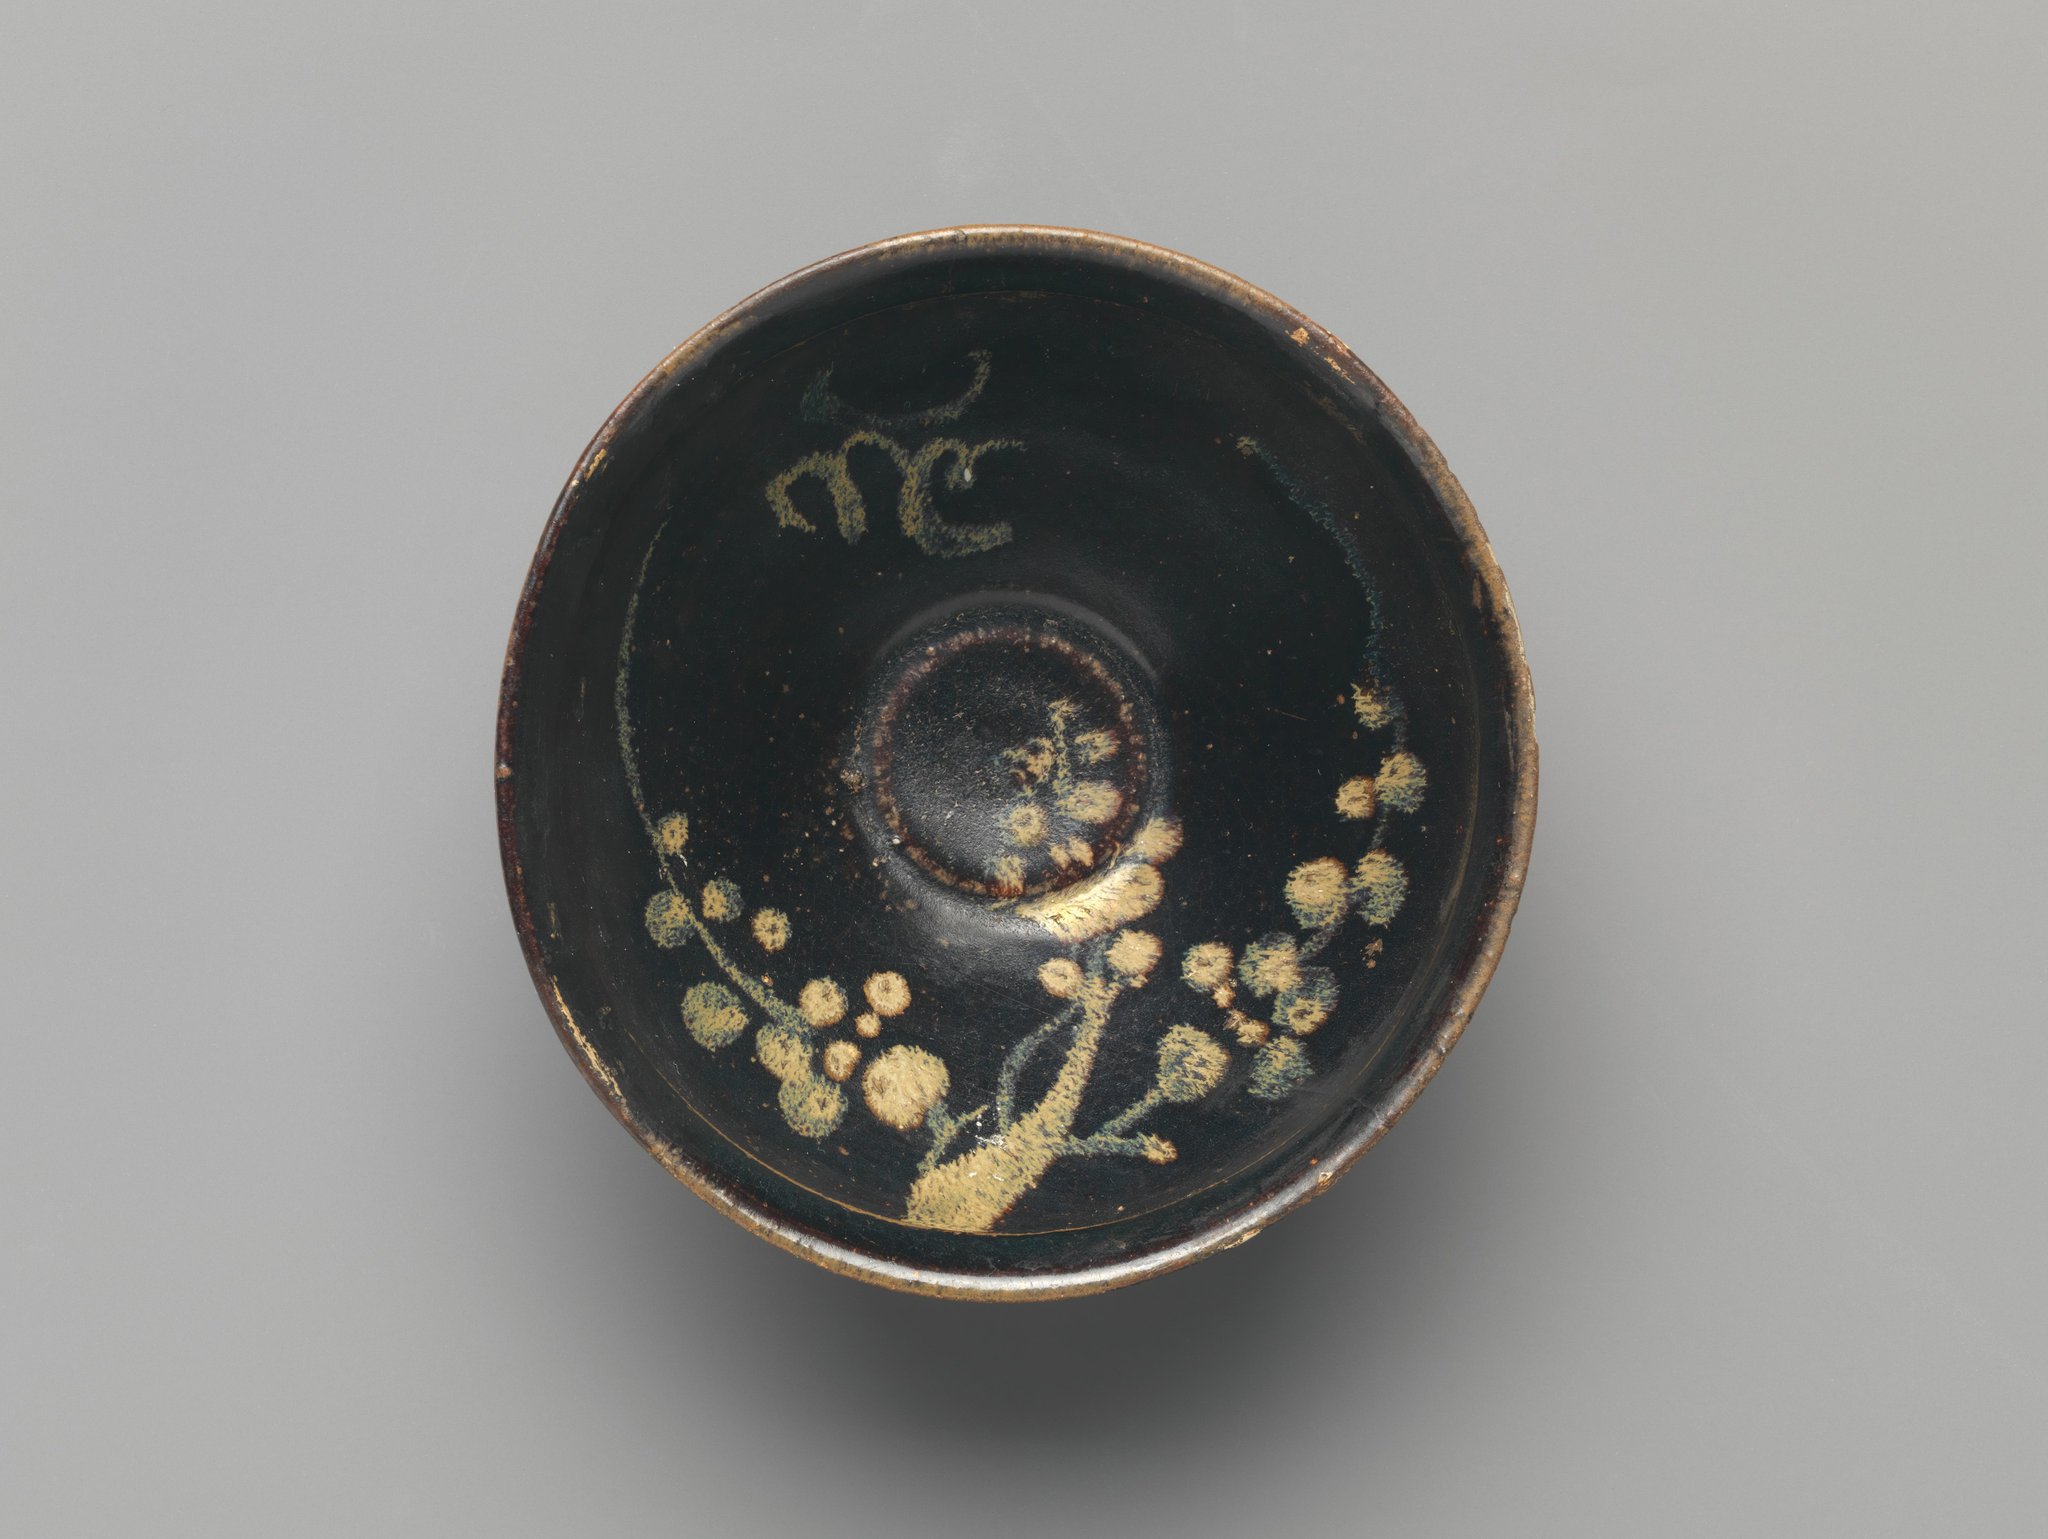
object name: bowl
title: Tea Bowl with Crescent Moon, Clouds, and Blossoming Plum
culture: chinese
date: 1201-1400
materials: glaze, pigment, stoneware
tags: flowers